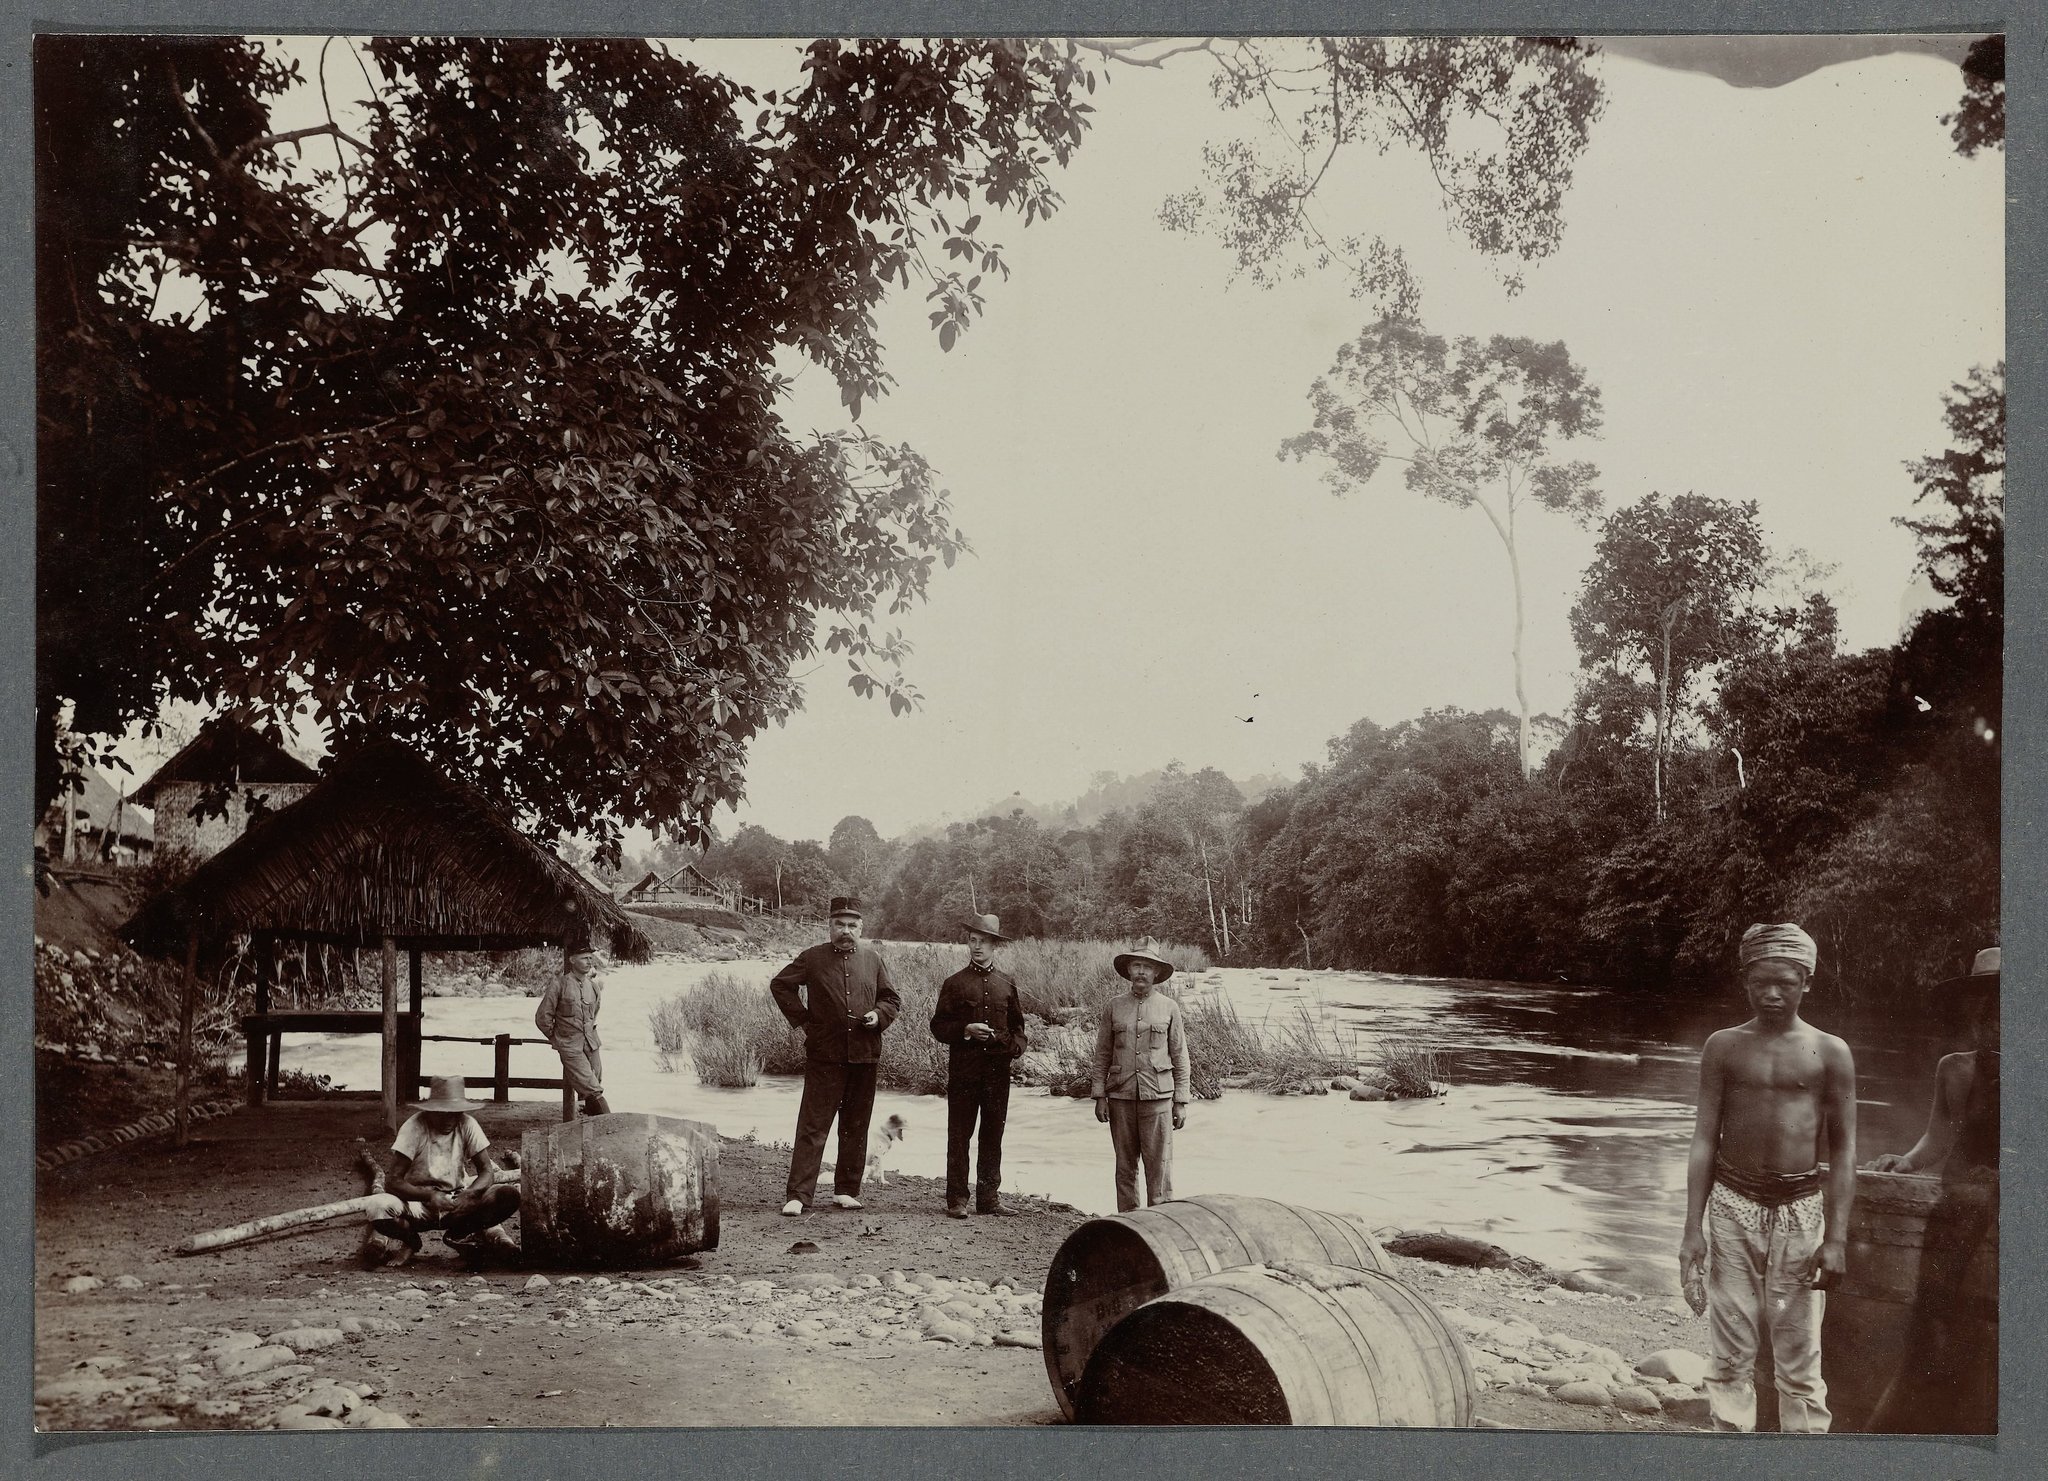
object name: photograph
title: Bivak te Krueng Seumpo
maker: Anonymous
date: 1903-1913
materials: photographic support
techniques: gelatin silver print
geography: north sumatra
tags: arnhem, the hague, albertus dominicus laman trip, building activities, river, traffic by road or path with motor-vehicle, landscapes in tropical and sub-tropical regions, road, path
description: Na de expedities naar de Gajo- en Alaslanden o.l.v. Van Daalen (eerste tocht in 1901), werd hij in 1903 belast met voorbereiding van permanente vestiging van Nederlands gezag. Aanleg van een weg van de Noordkust naar het binnenland was hierbij van groot belang. Deze zgn. Gajoweg werd aangelegd tussen 1903 en 1914, van Bireuen aan de kust naar Takinguen aan het bergmeer Danau Lauttawar, totale lengte 104 km.